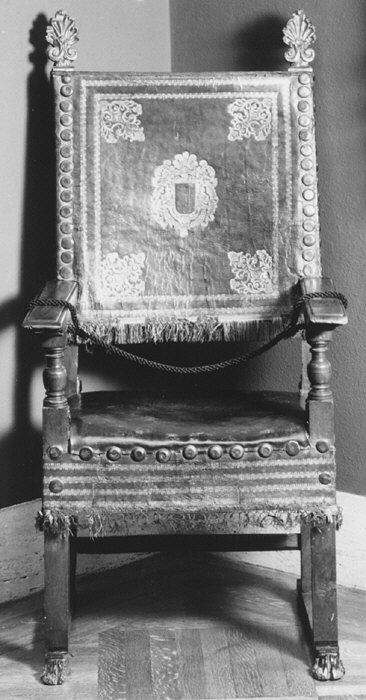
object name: armchair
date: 1501-1700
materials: leather, wood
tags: coat of arms